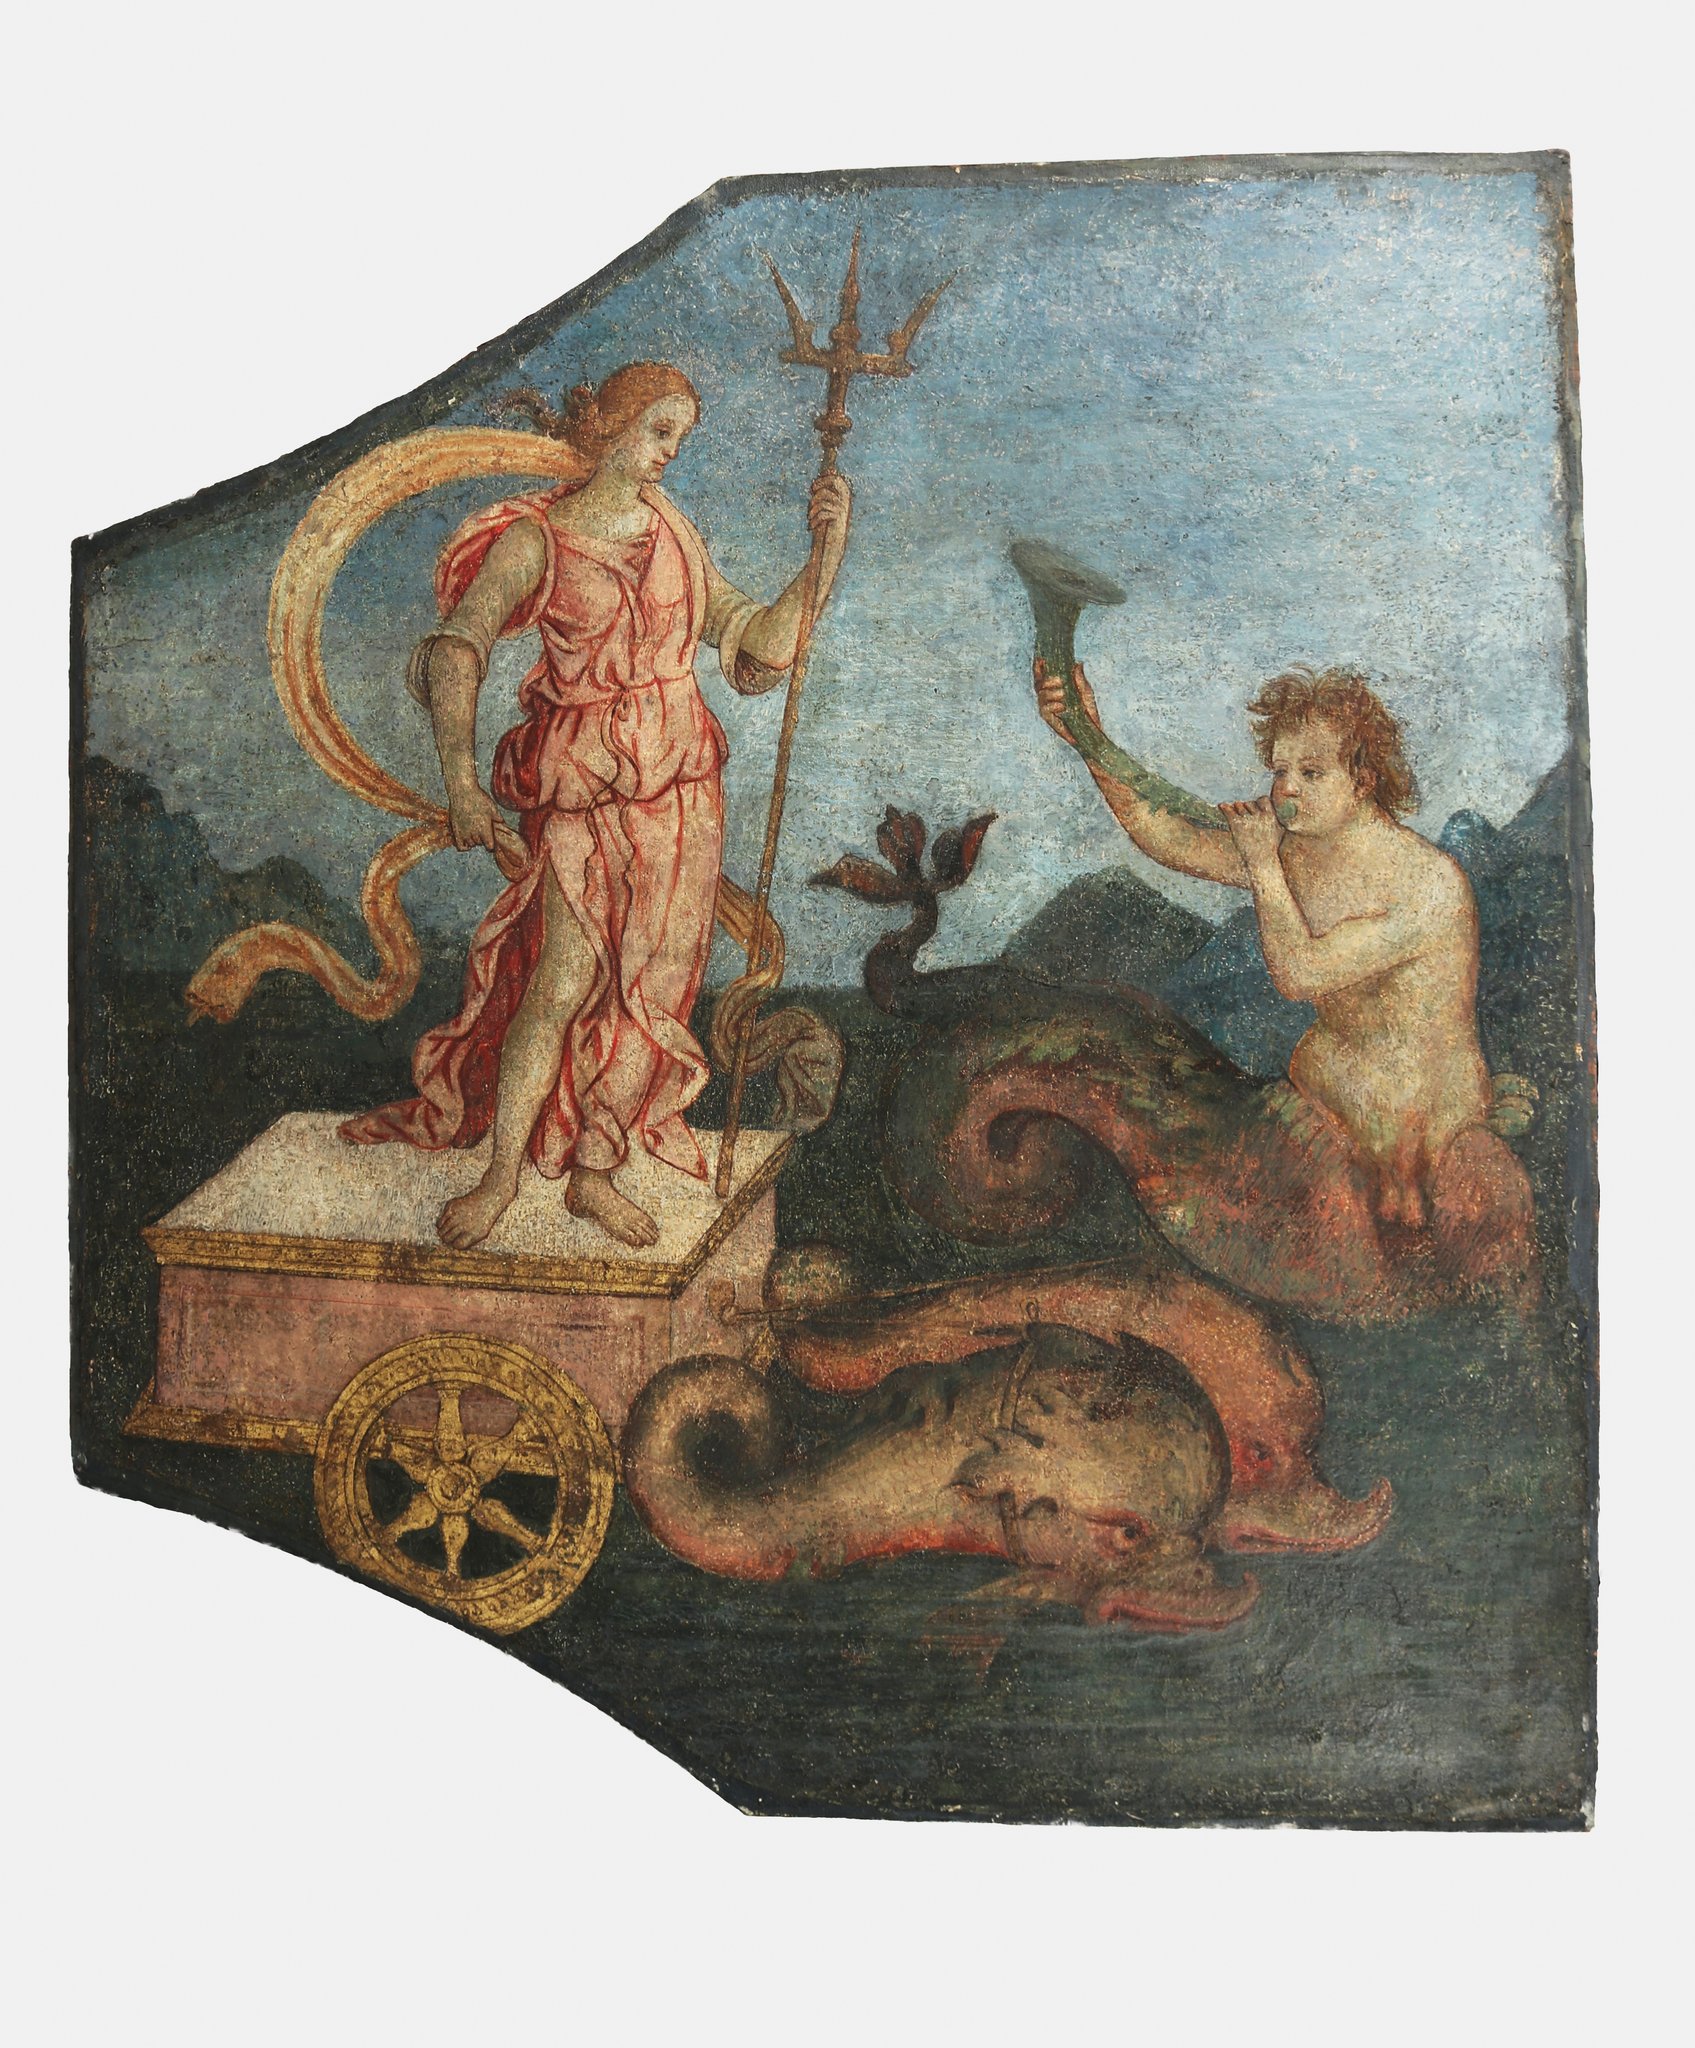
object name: ceiling panel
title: Triumph of Amphitrite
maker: pinturicchio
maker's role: artist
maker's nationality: italian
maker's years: 1454-1513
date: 1509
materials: canvas, panel, wood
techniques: fresco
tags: horns,dolphins,chariots